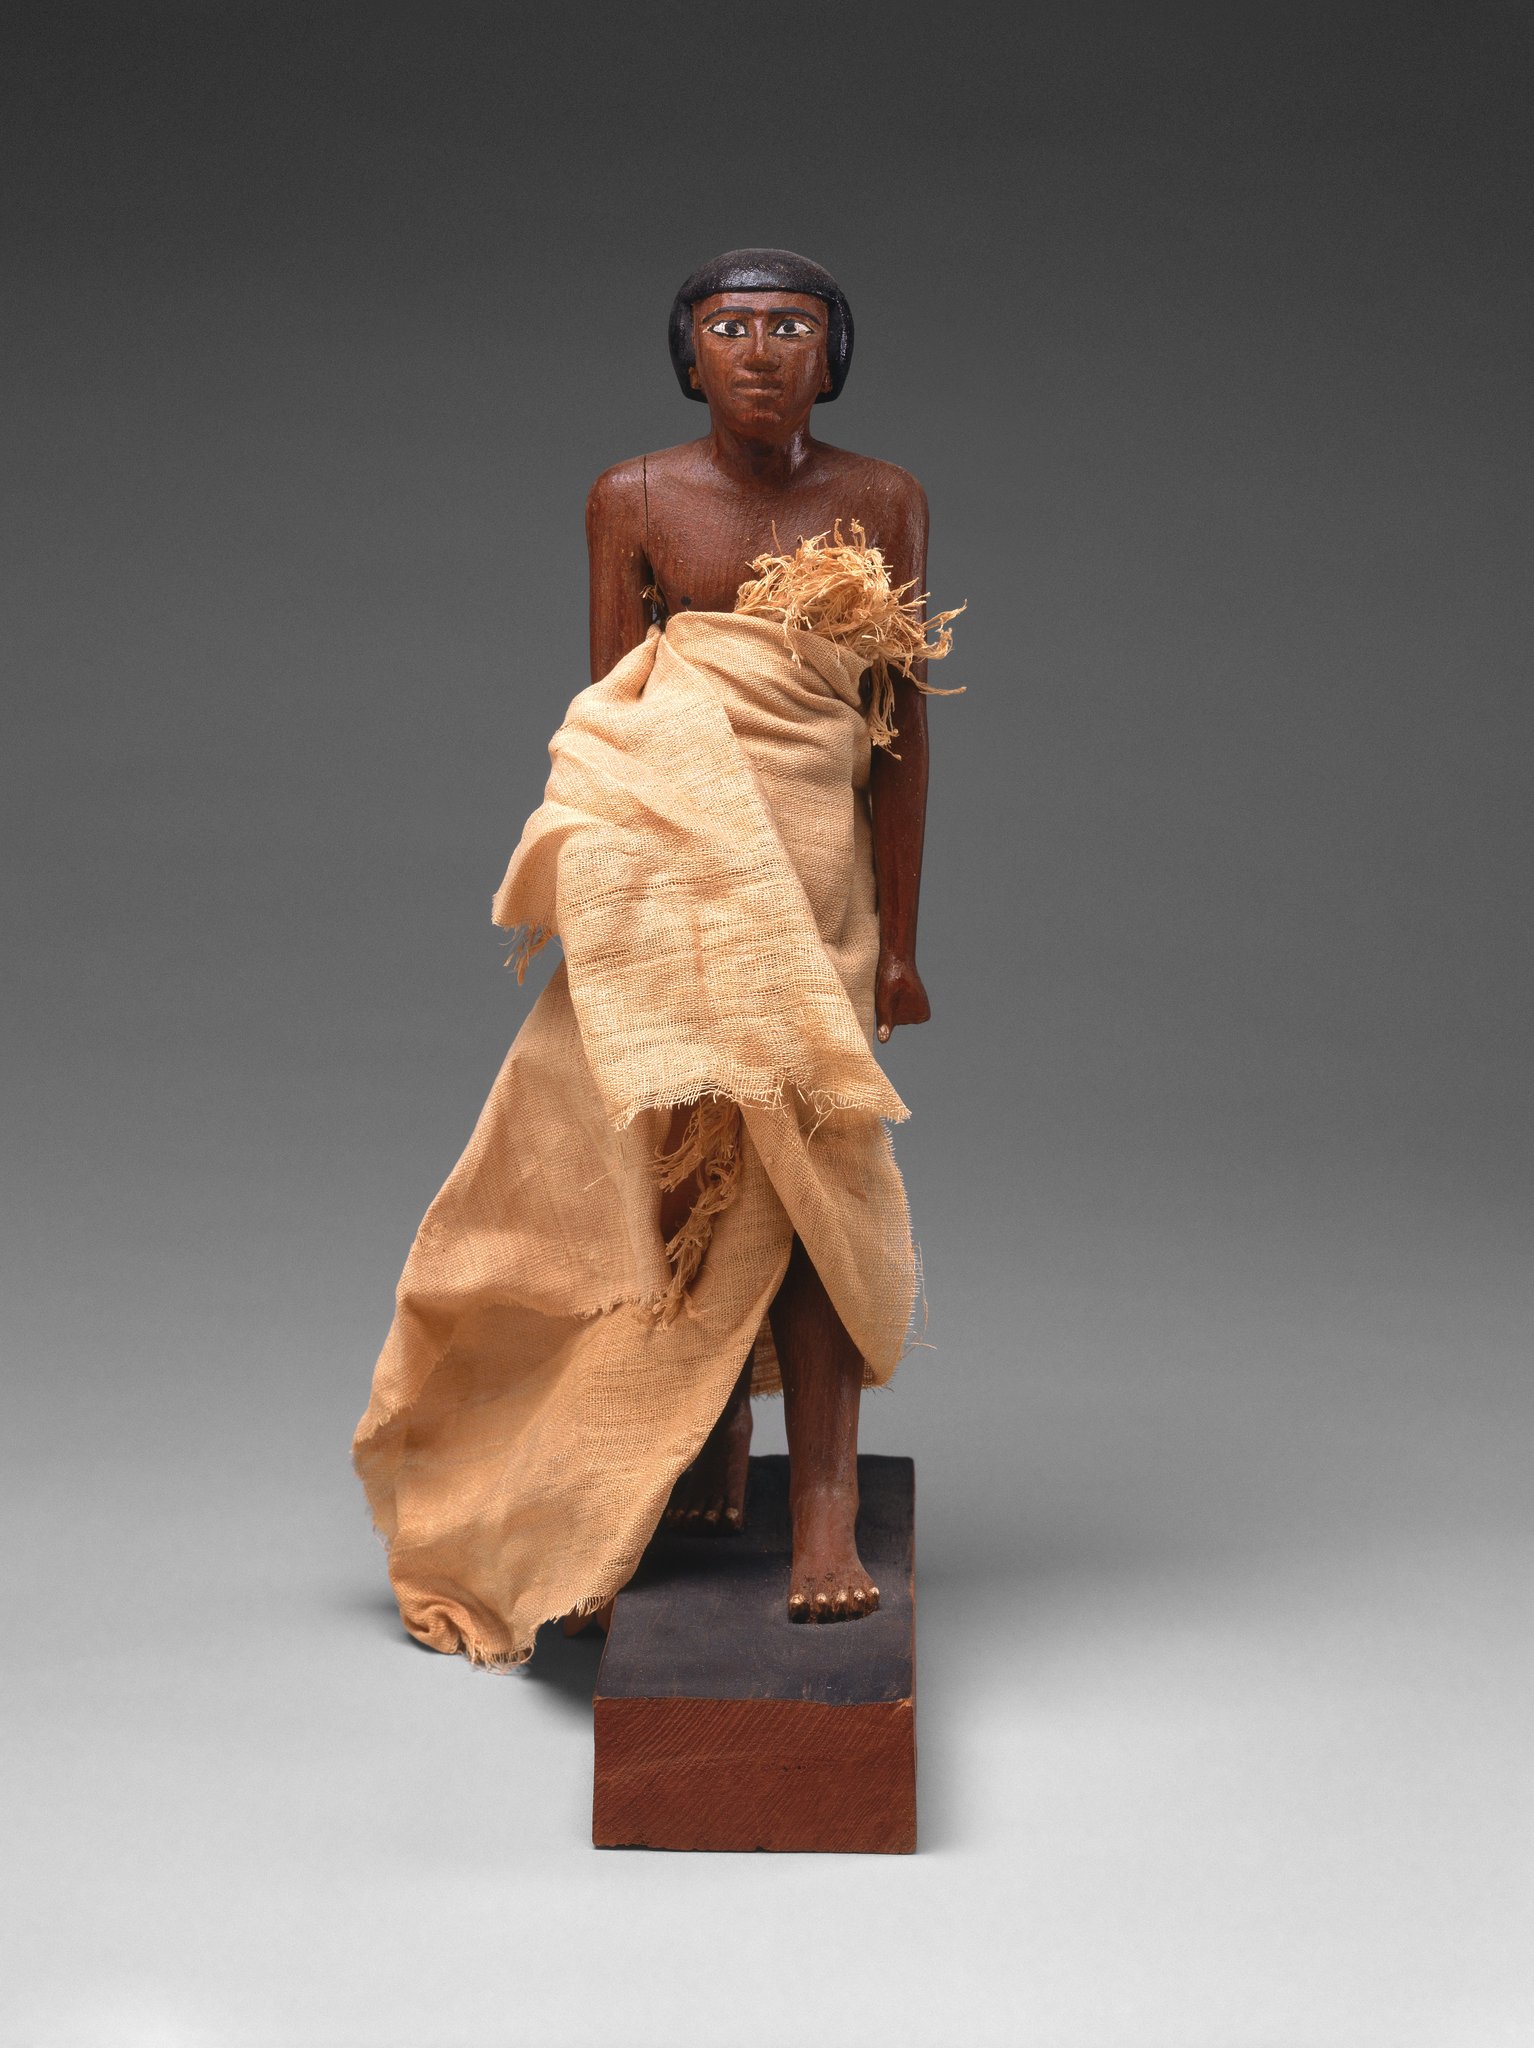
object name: statuette, standing man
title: Statuette of Wah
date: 1981-1975 BCE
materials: wood, linen, paint, plaster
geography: egypt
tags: men